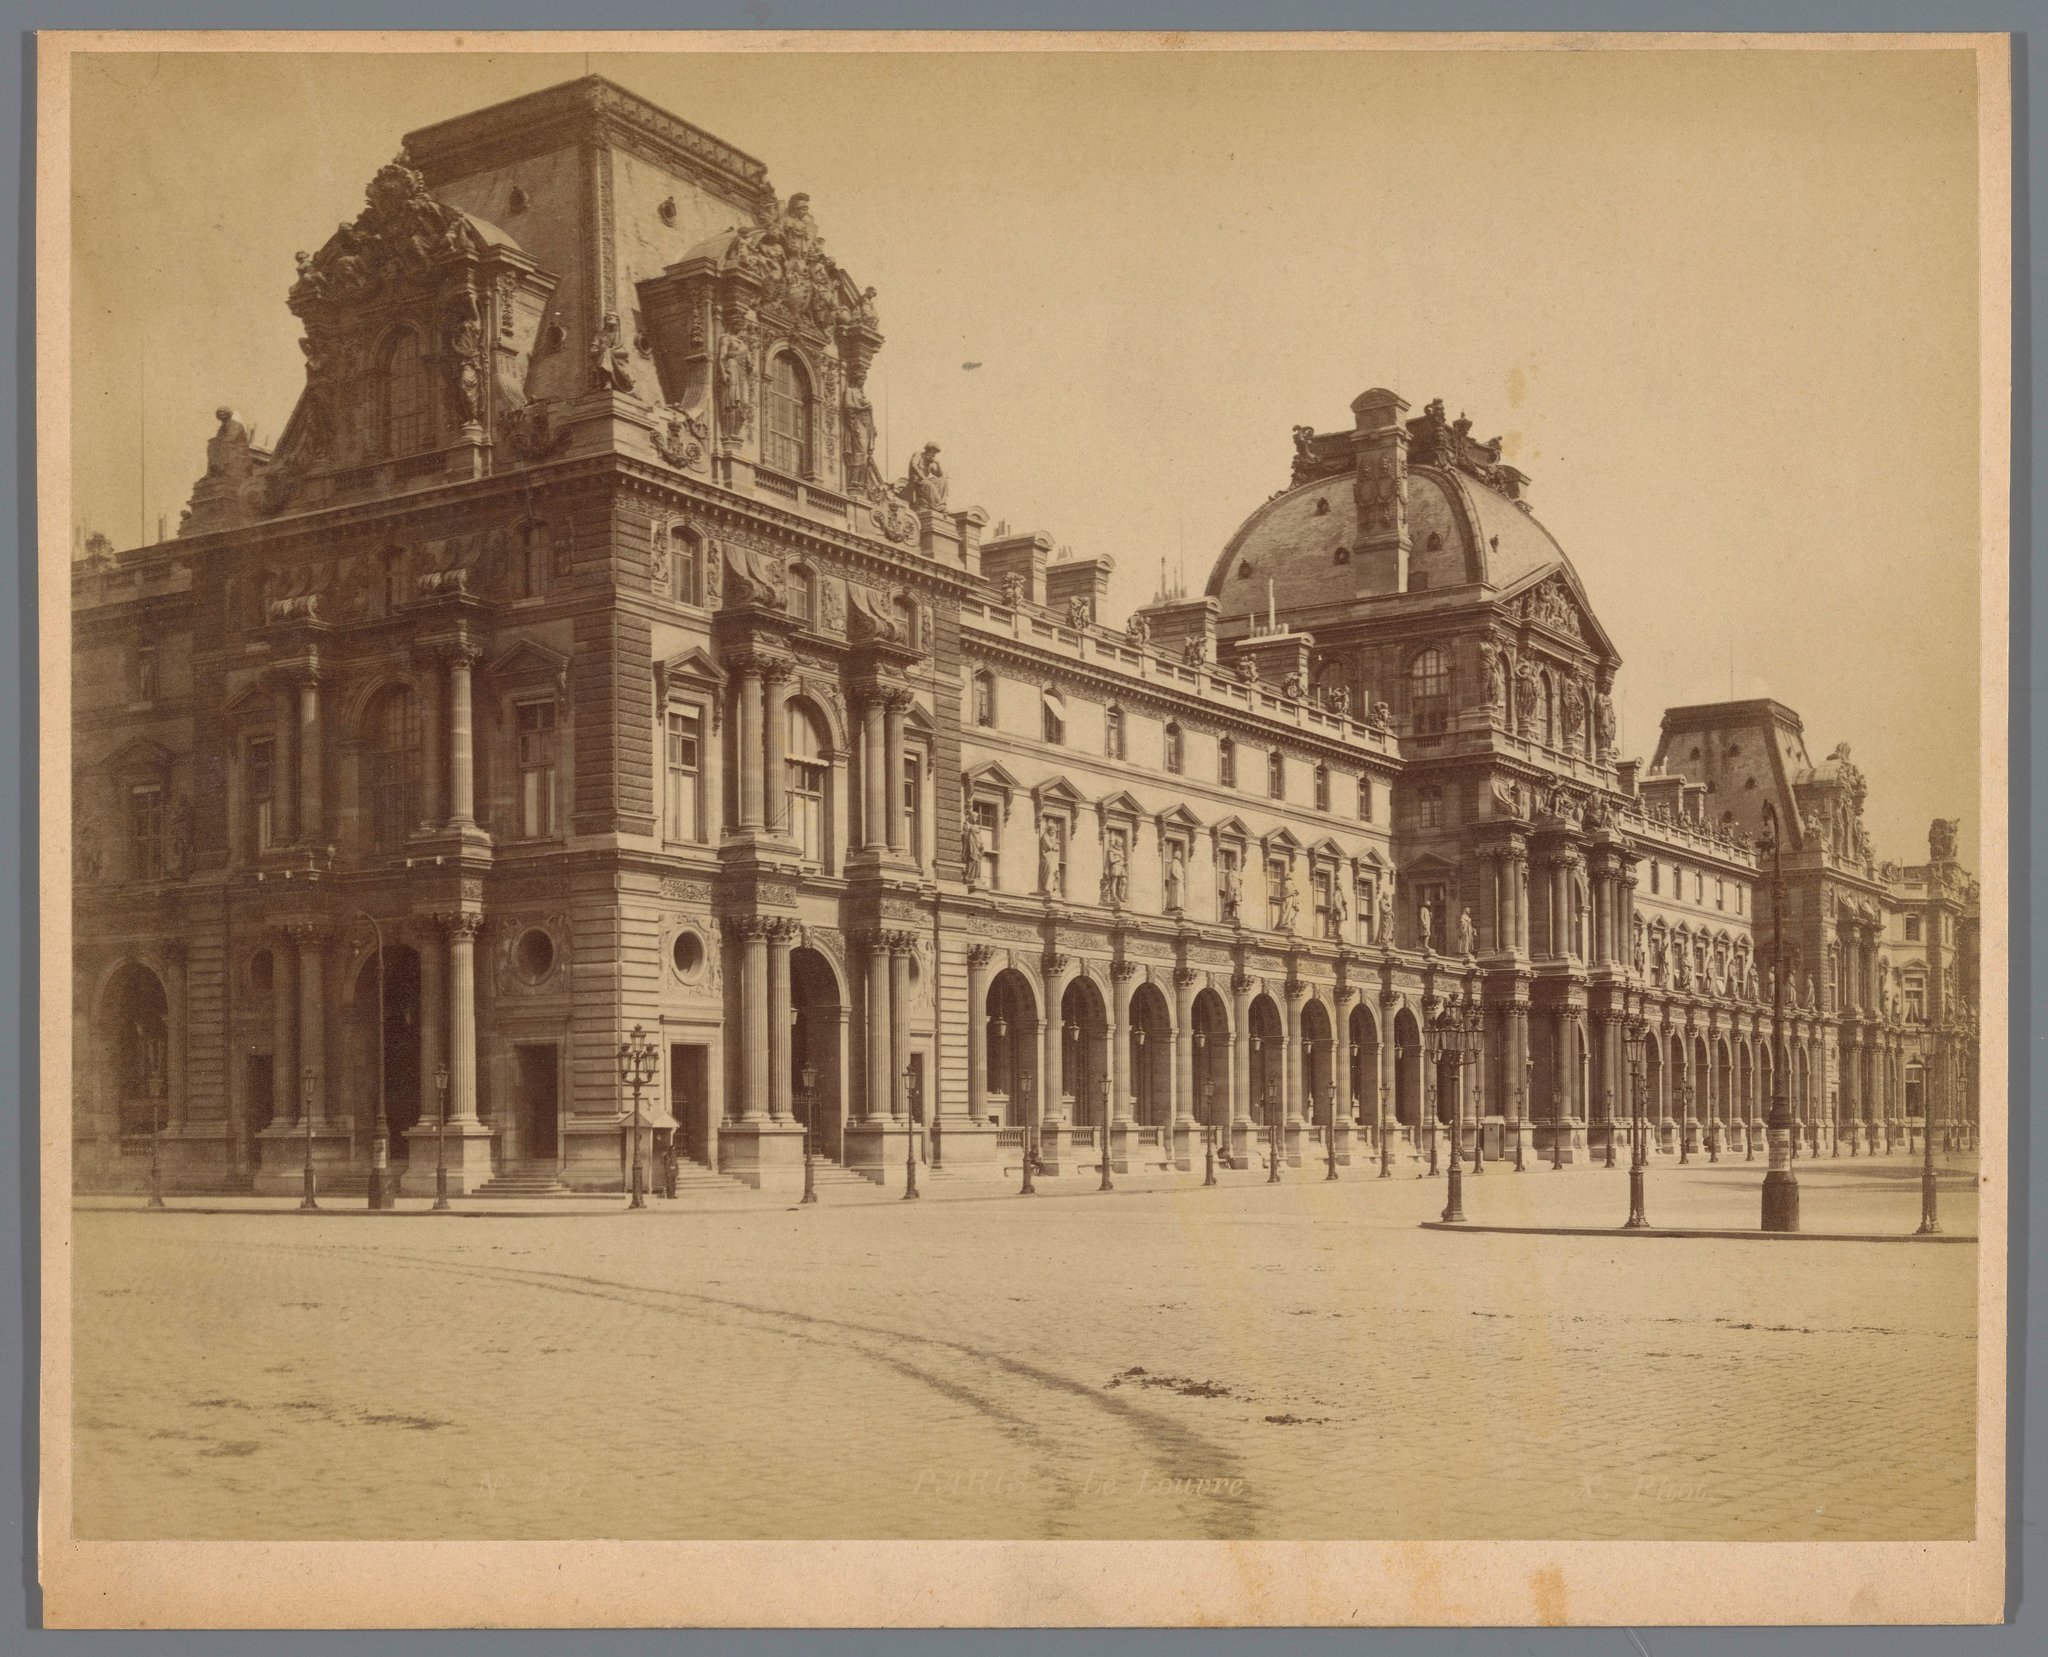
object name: photograph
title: Paris - Le Louvre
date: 1887-1900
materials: cardboard, paper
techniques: albumen print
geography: paris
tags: palace, permanent exhibition, museum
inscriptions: inscription: ‘No 227 Paris - Le Louvre X. Phot.’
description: Tussen 1887 en ca. 1900 werkten Neurdein frères onder andere onder de naam 'X phot.'.